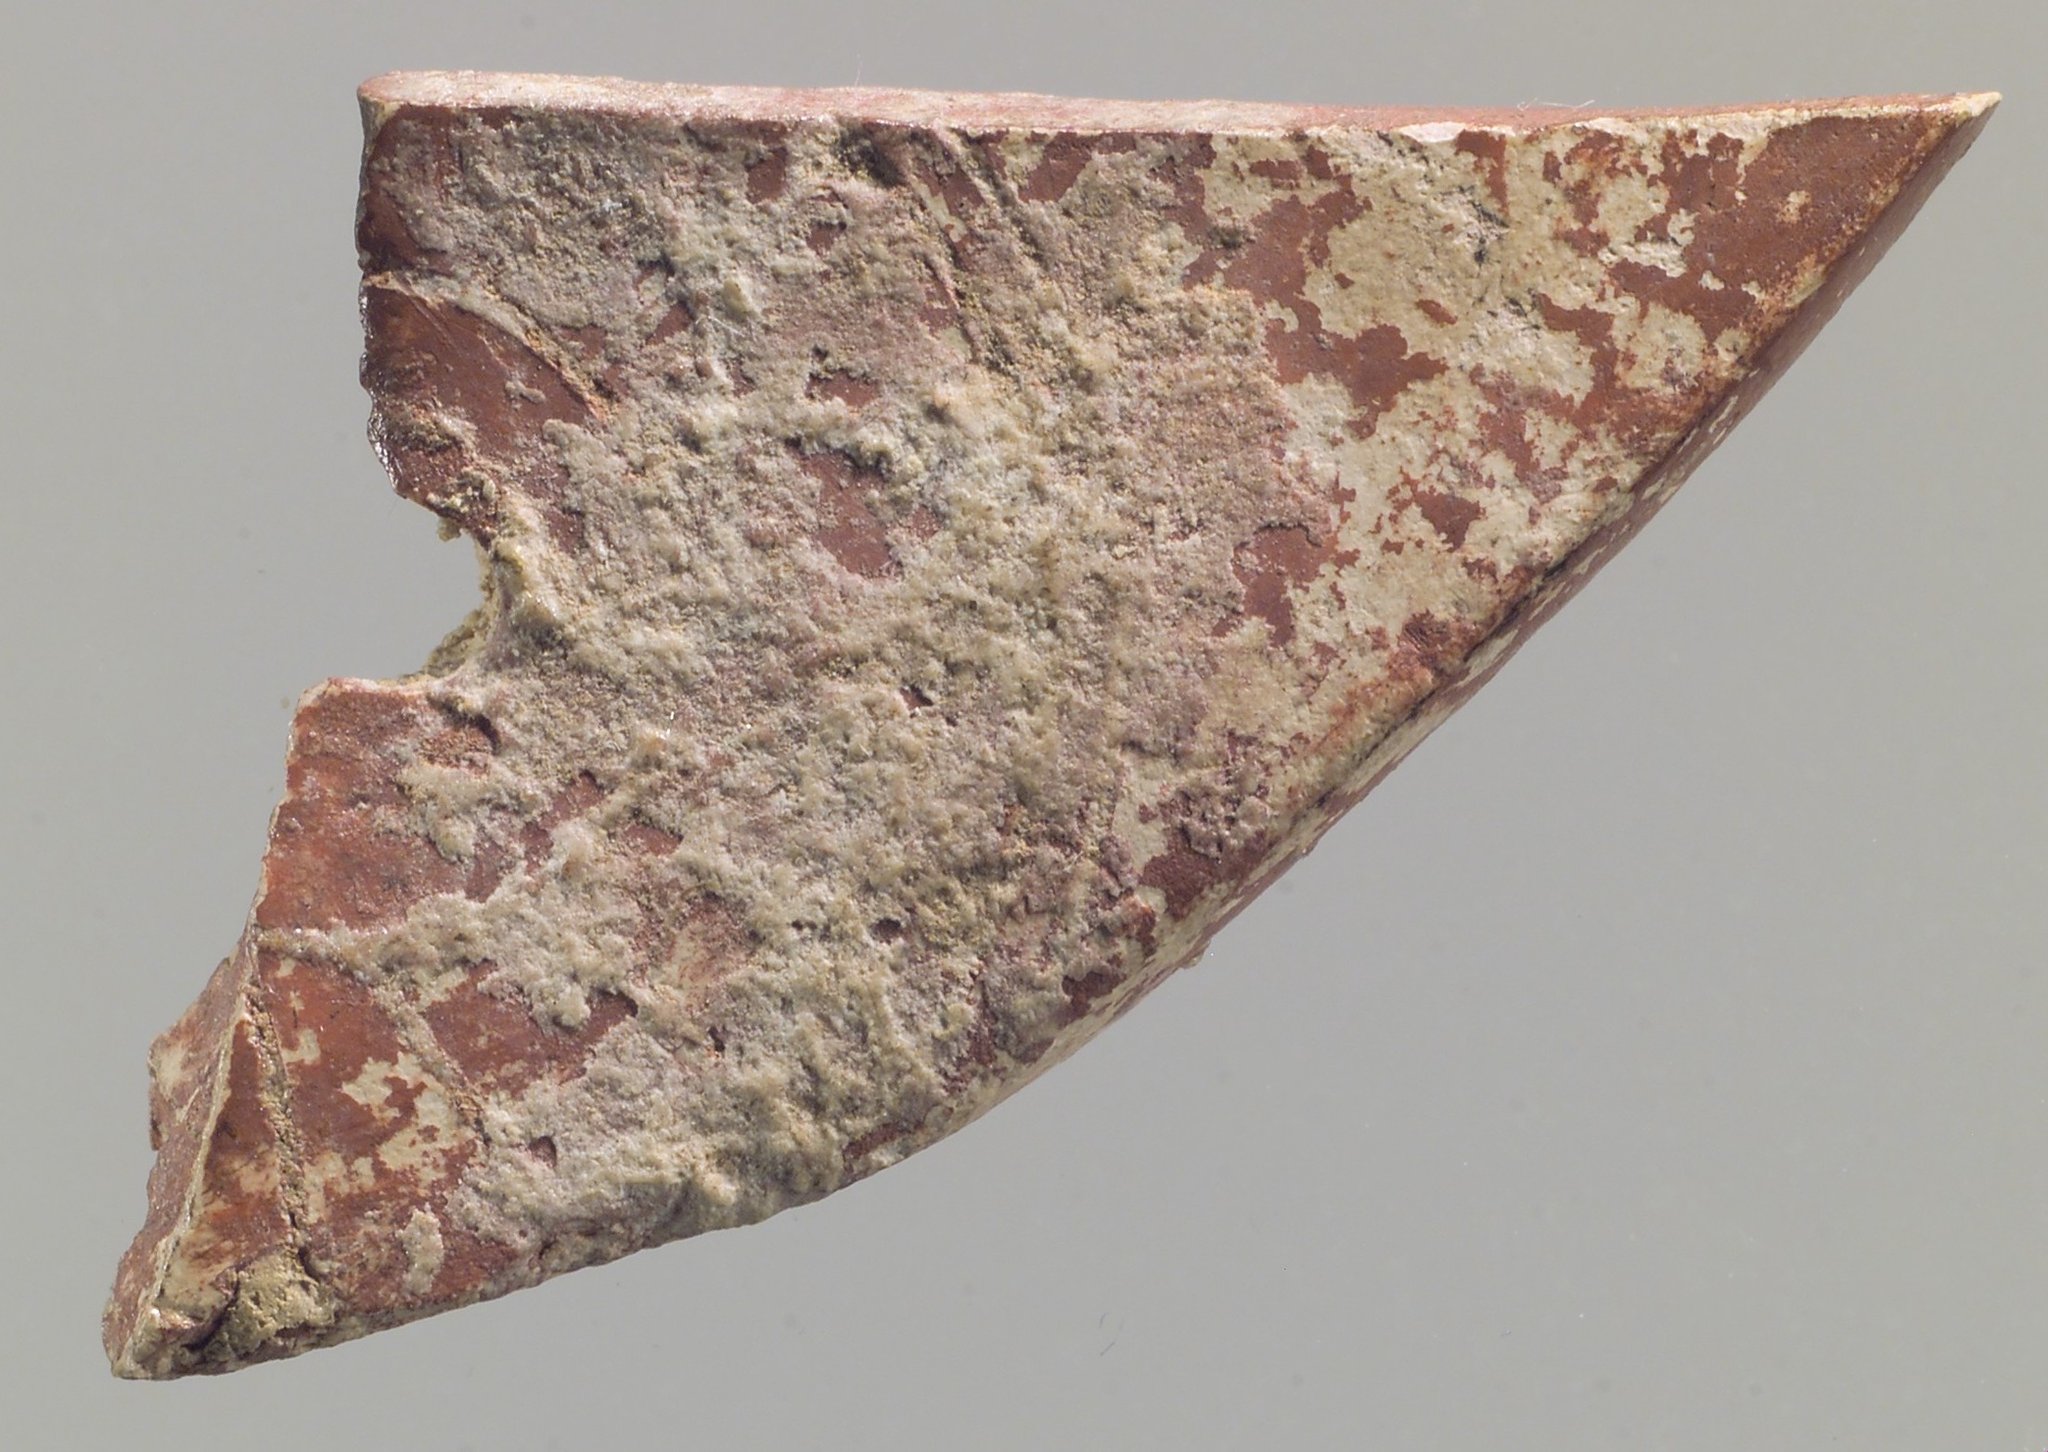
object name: plaque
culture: assyrian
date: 1800-1701 BCE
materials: ivory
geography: anatolia